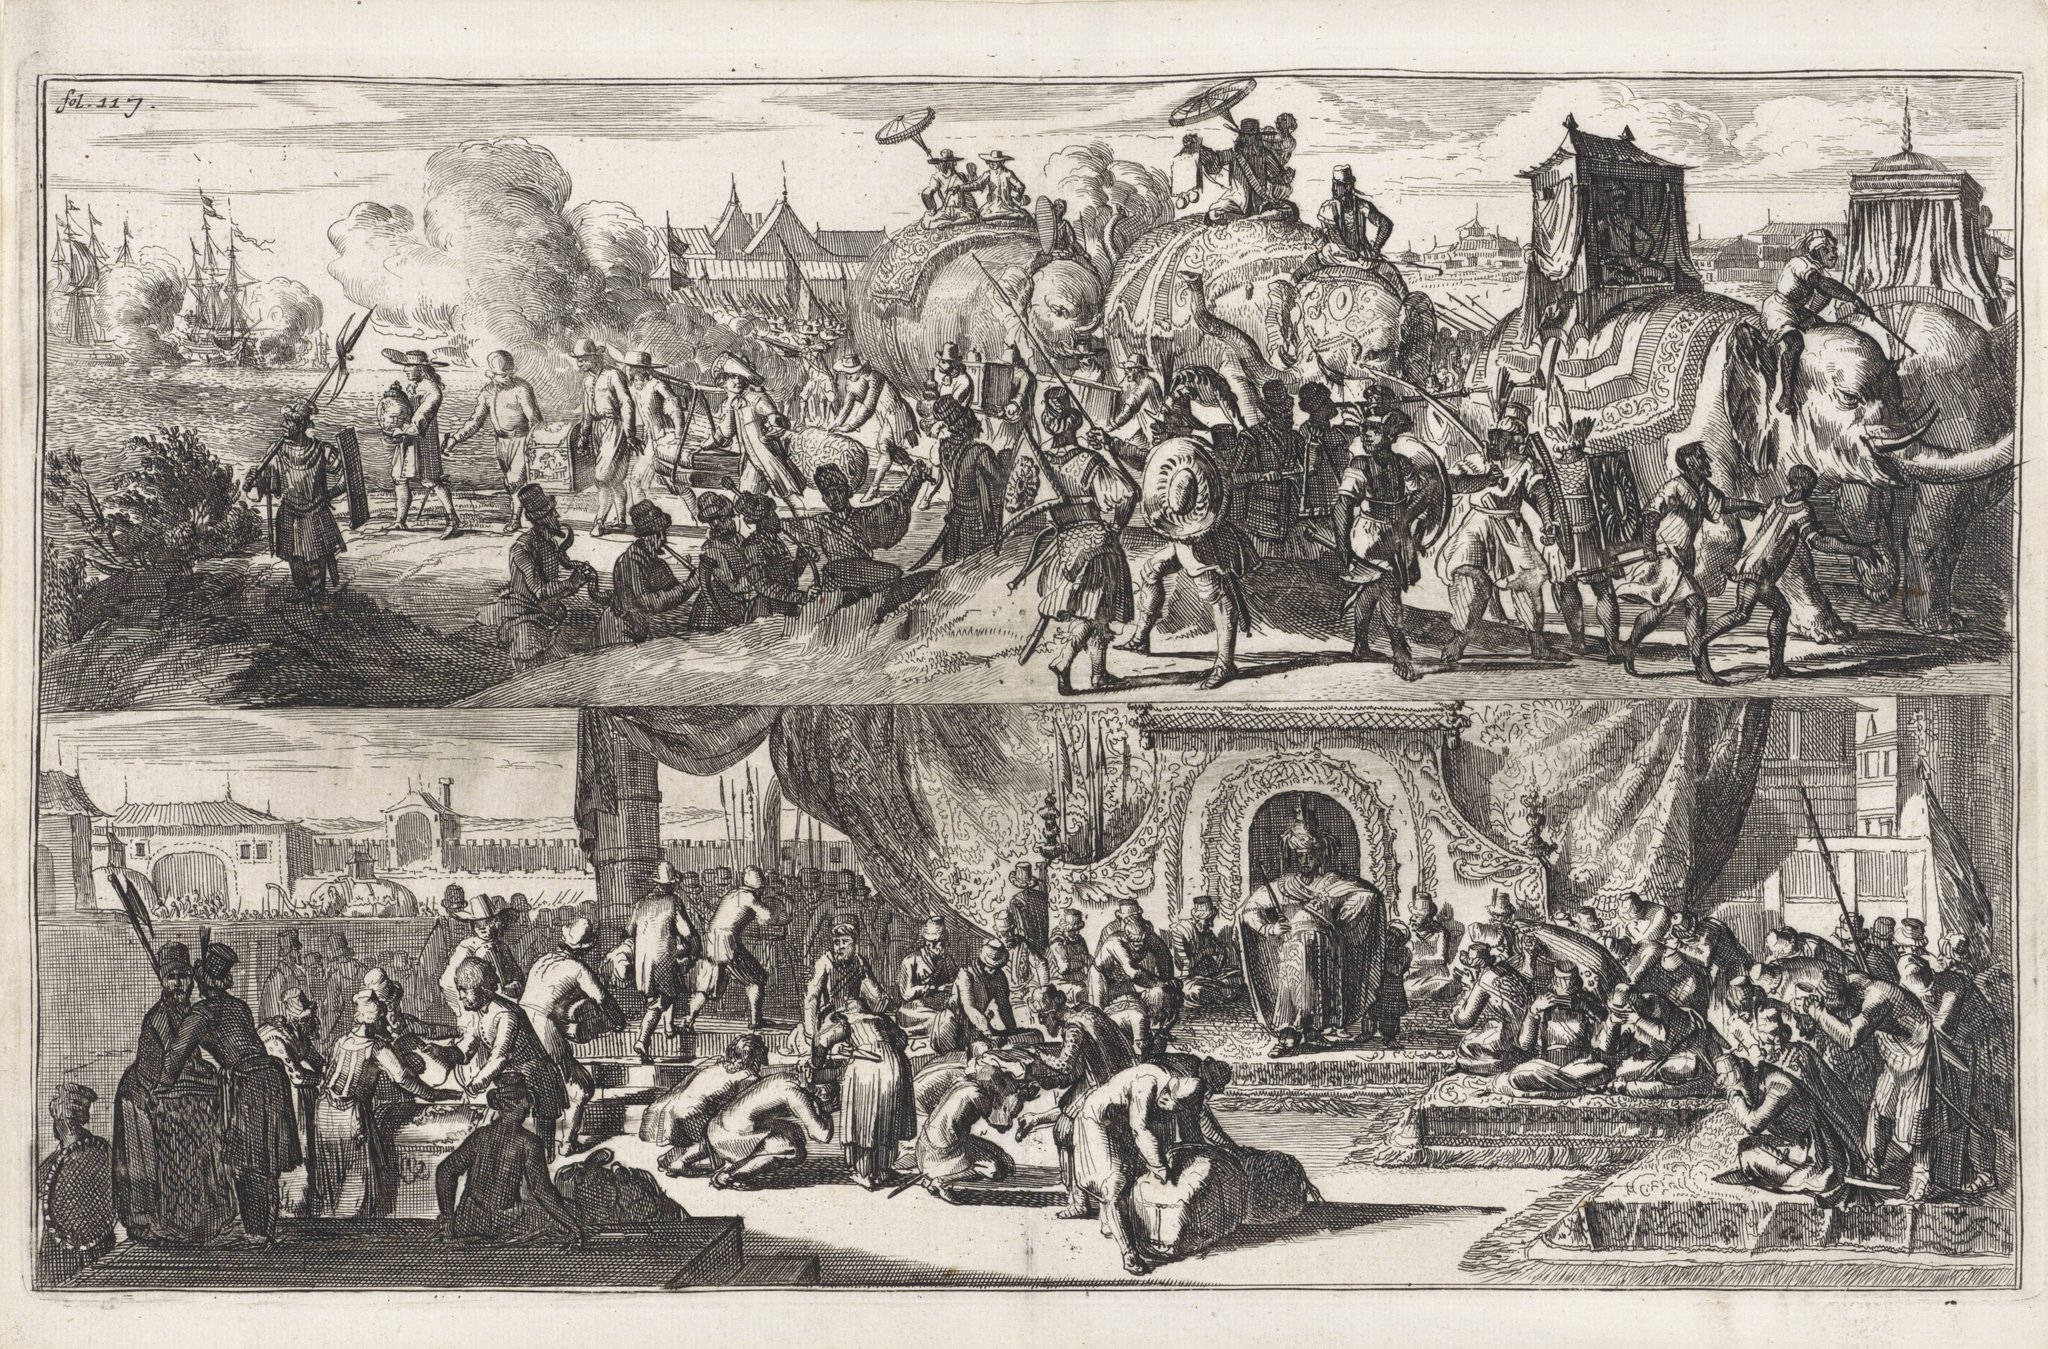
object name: print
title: Stoet olifanten en figuren bij een heerser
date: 1676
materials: paper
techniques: etching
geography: low countries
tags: carrying something, trunked animals: elephant (+ man and animal), the soldier; the soldier's life, battle (+ sailing-ships), making a bow to a ruler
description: Boven enkele figuren op een stoet olifanten. Vooraan maken soldaten muziek en achter hen dragen mannen goederen naar het water. Links in de verte een zeeslag. Onder buigt een grote groep mensen voor een heerser. Links brengen figuren goederen, waarschijnlijk geschenken. Linksboven: fol. 117.